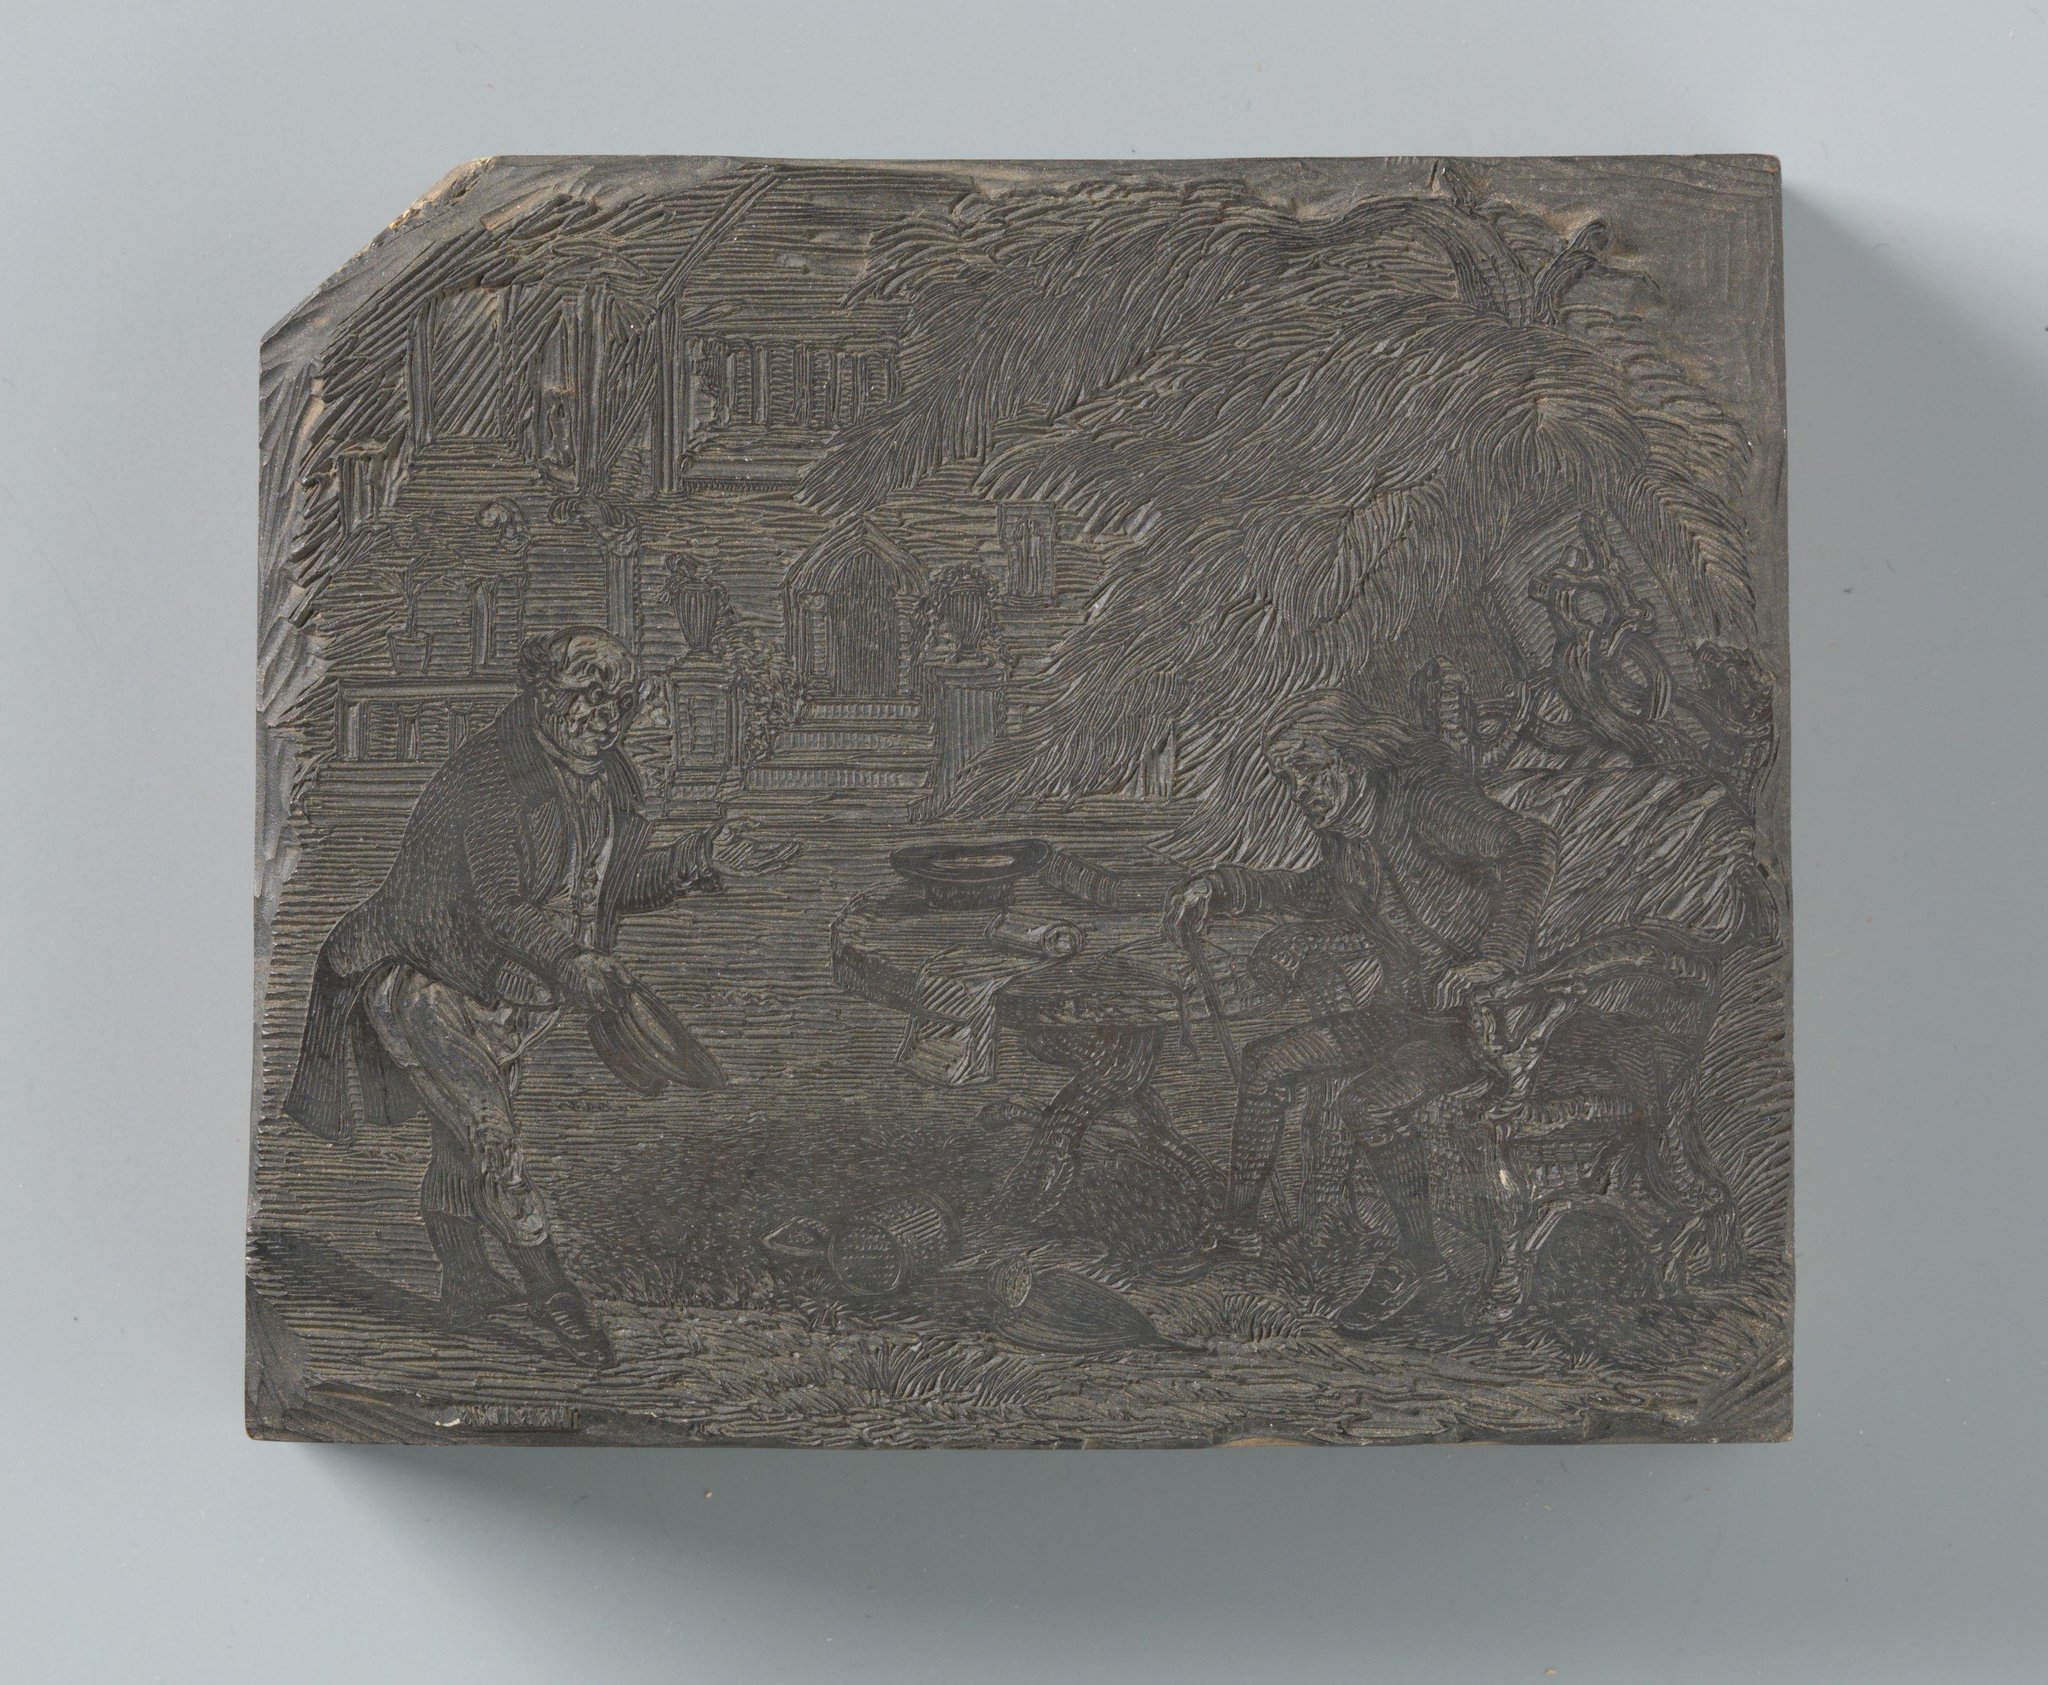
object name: wood block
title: Scène in een tuin tussen een oude man in een stoel en een buigende man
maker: willem bal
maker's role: print maker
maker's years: 1808-1897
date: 1818-1897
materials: wood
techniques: engraving